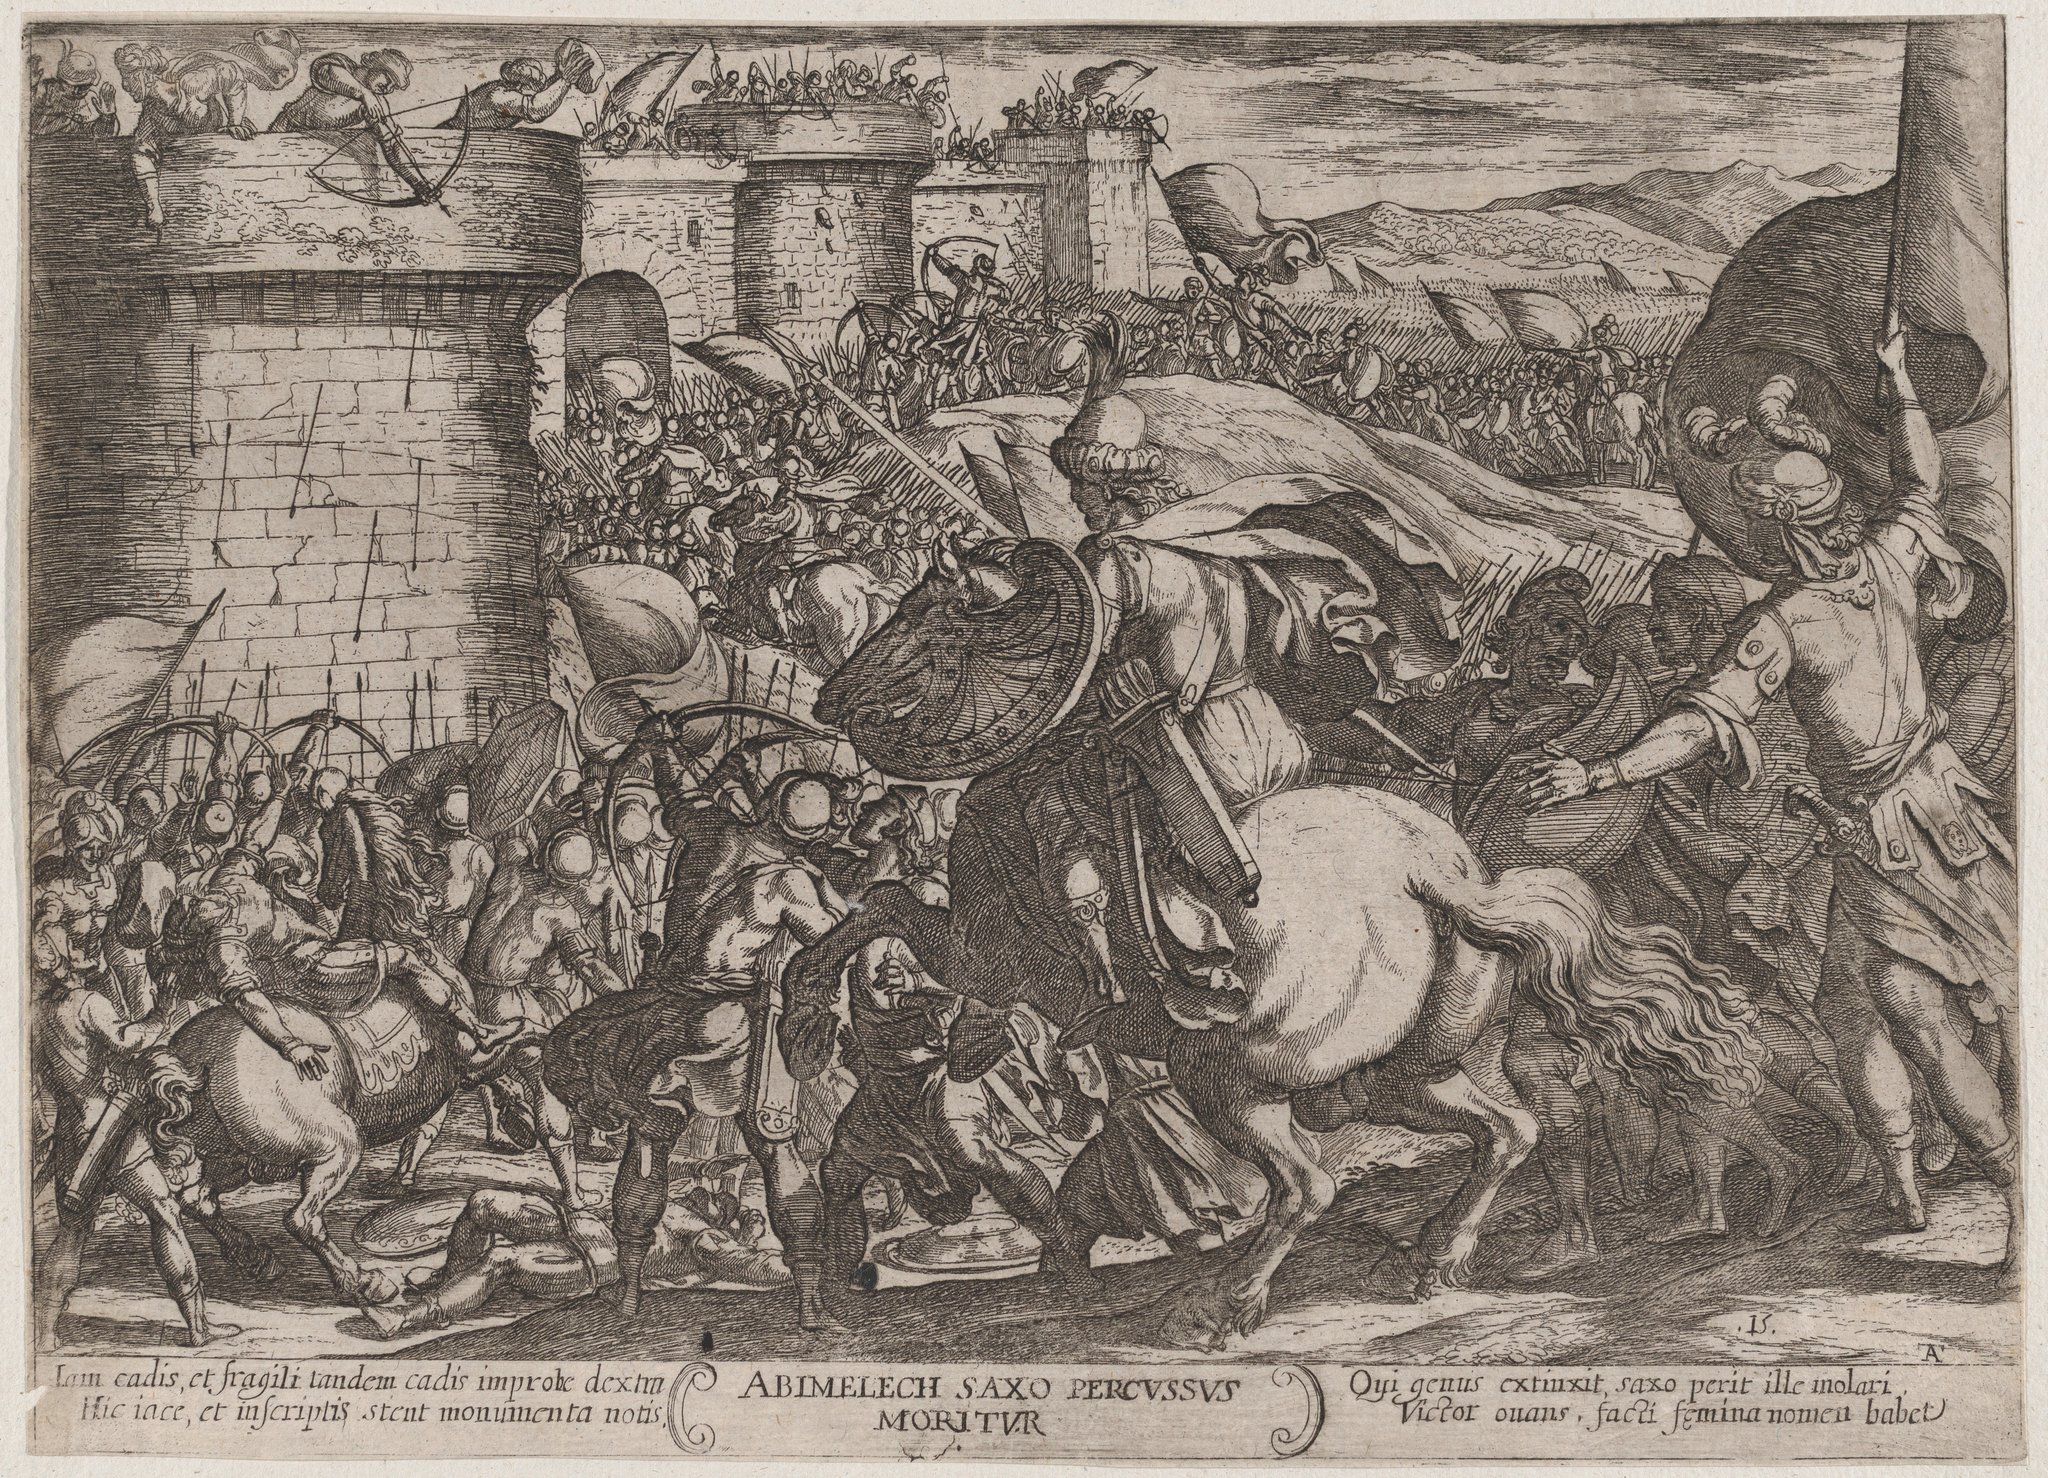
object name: print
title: Plate 15: The Death of Abimelech, from "The Battles of the Old Testament"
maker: antonio tempesta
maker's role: artist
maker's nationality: italian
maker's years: 1555-1630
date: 1590-1610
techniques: etching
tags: battles,soldiers,men,horses